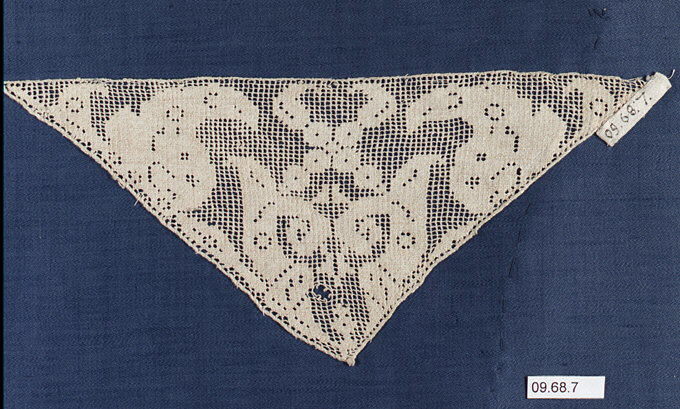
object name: piece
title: Triangular piece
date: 1600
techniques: embroidery